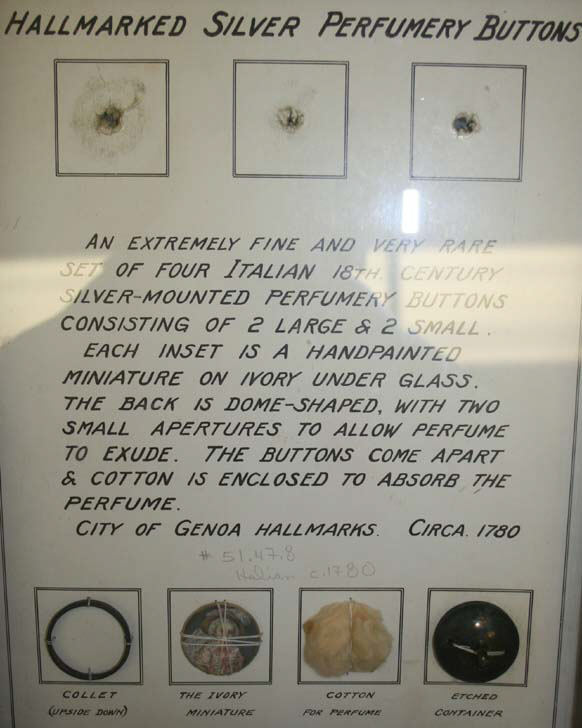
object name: button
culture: italian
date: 1780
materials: ivory, metal